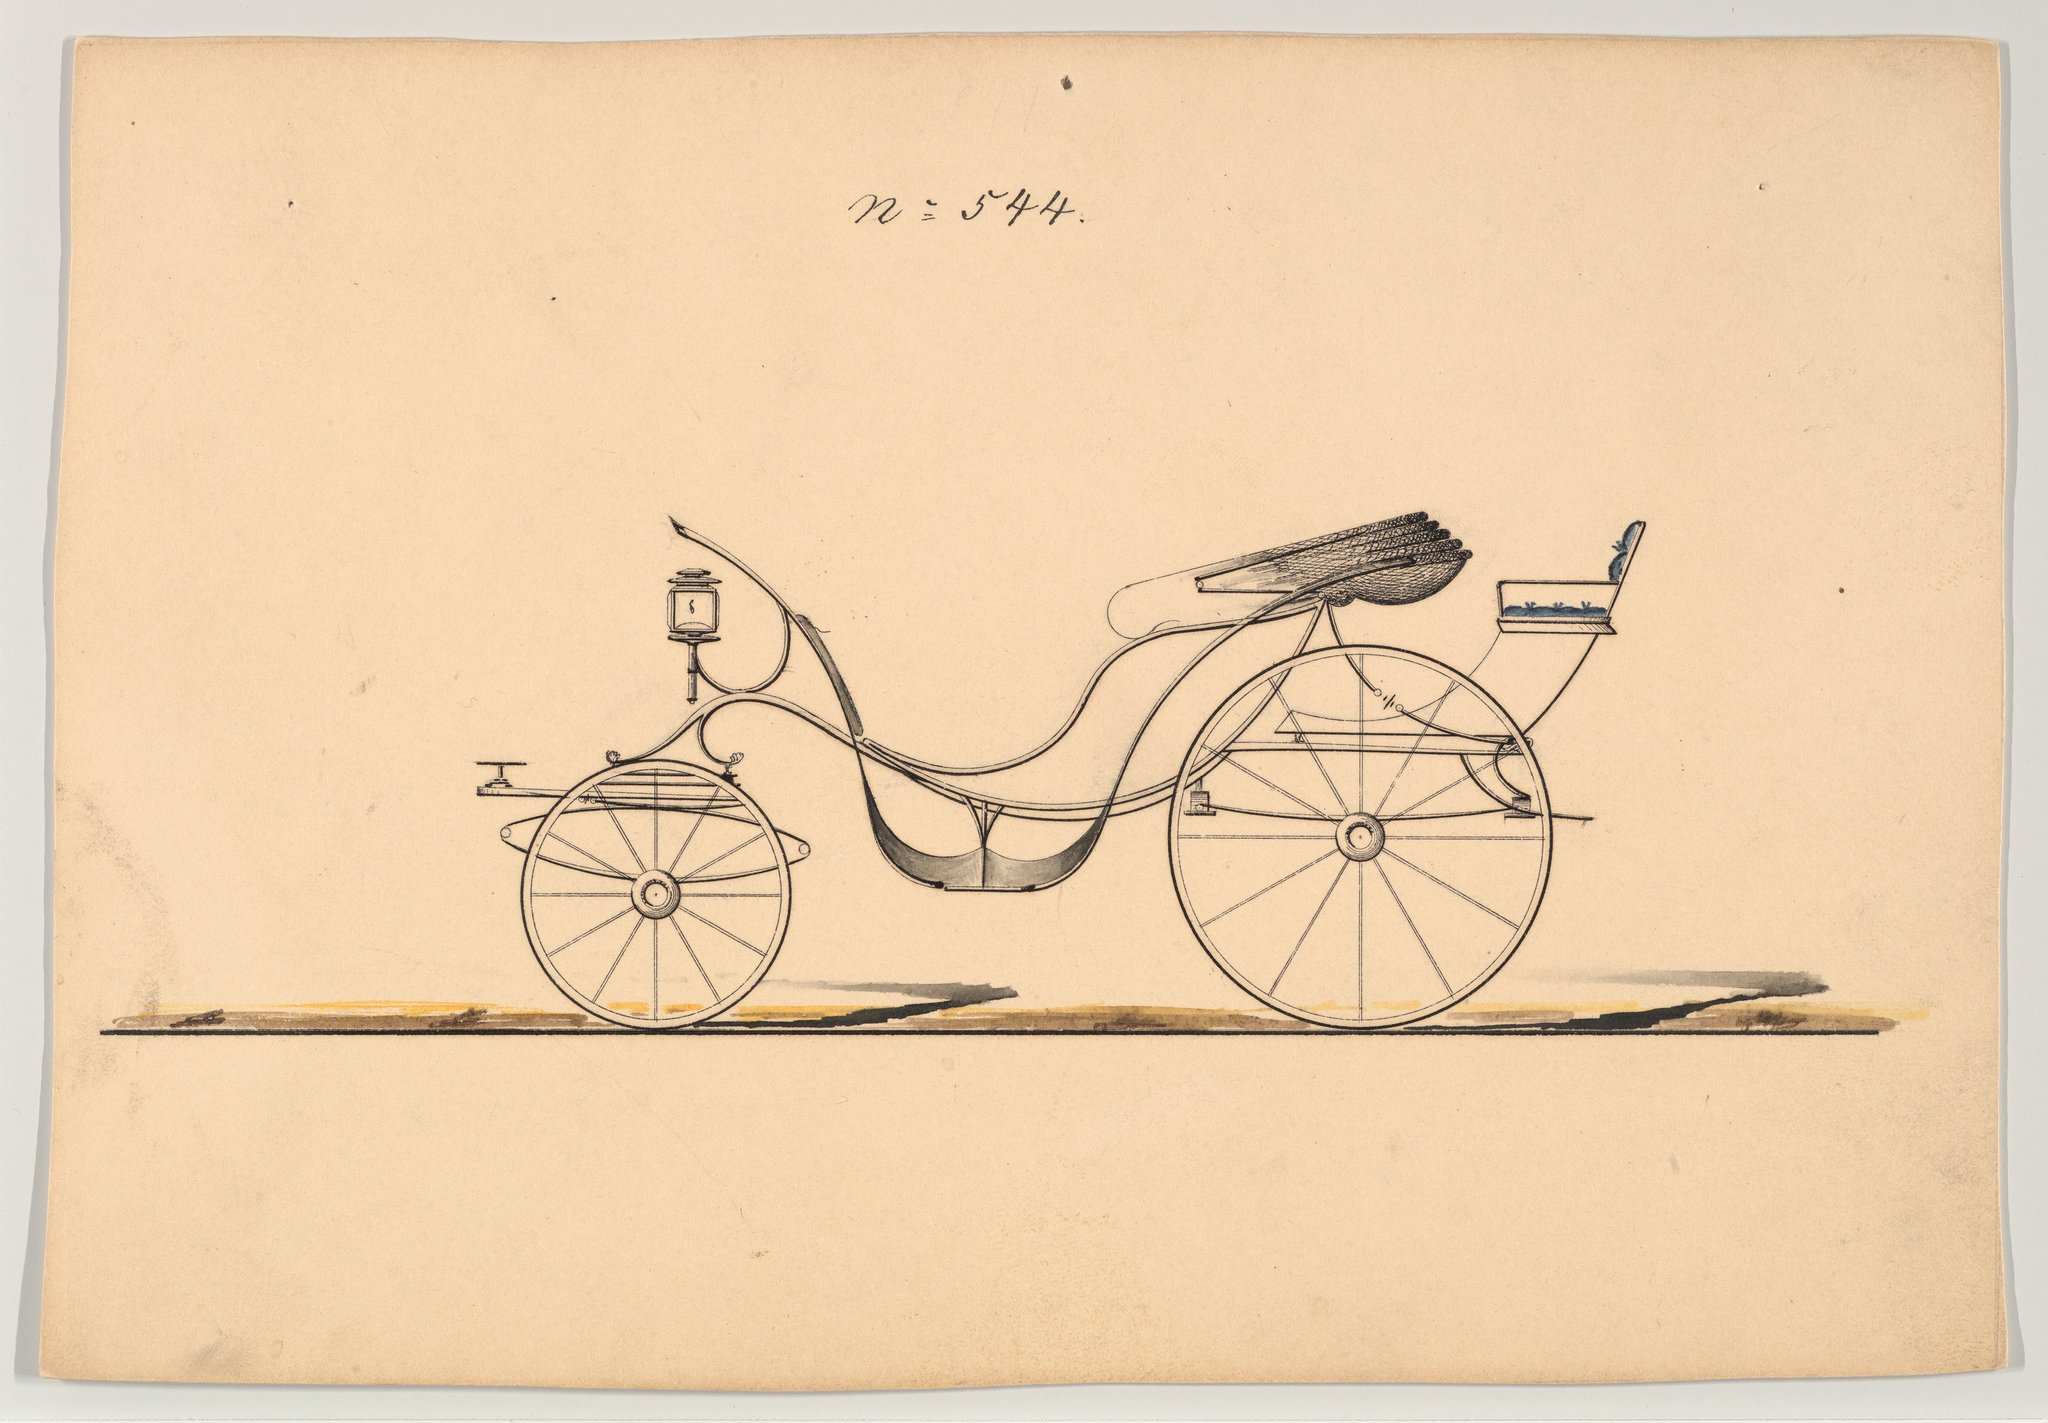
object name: drawing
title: Phaeton #544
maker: brewster & co.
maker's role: manufacturer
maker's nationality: american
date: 1860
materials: ink, watercolor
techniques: pen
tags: carriages